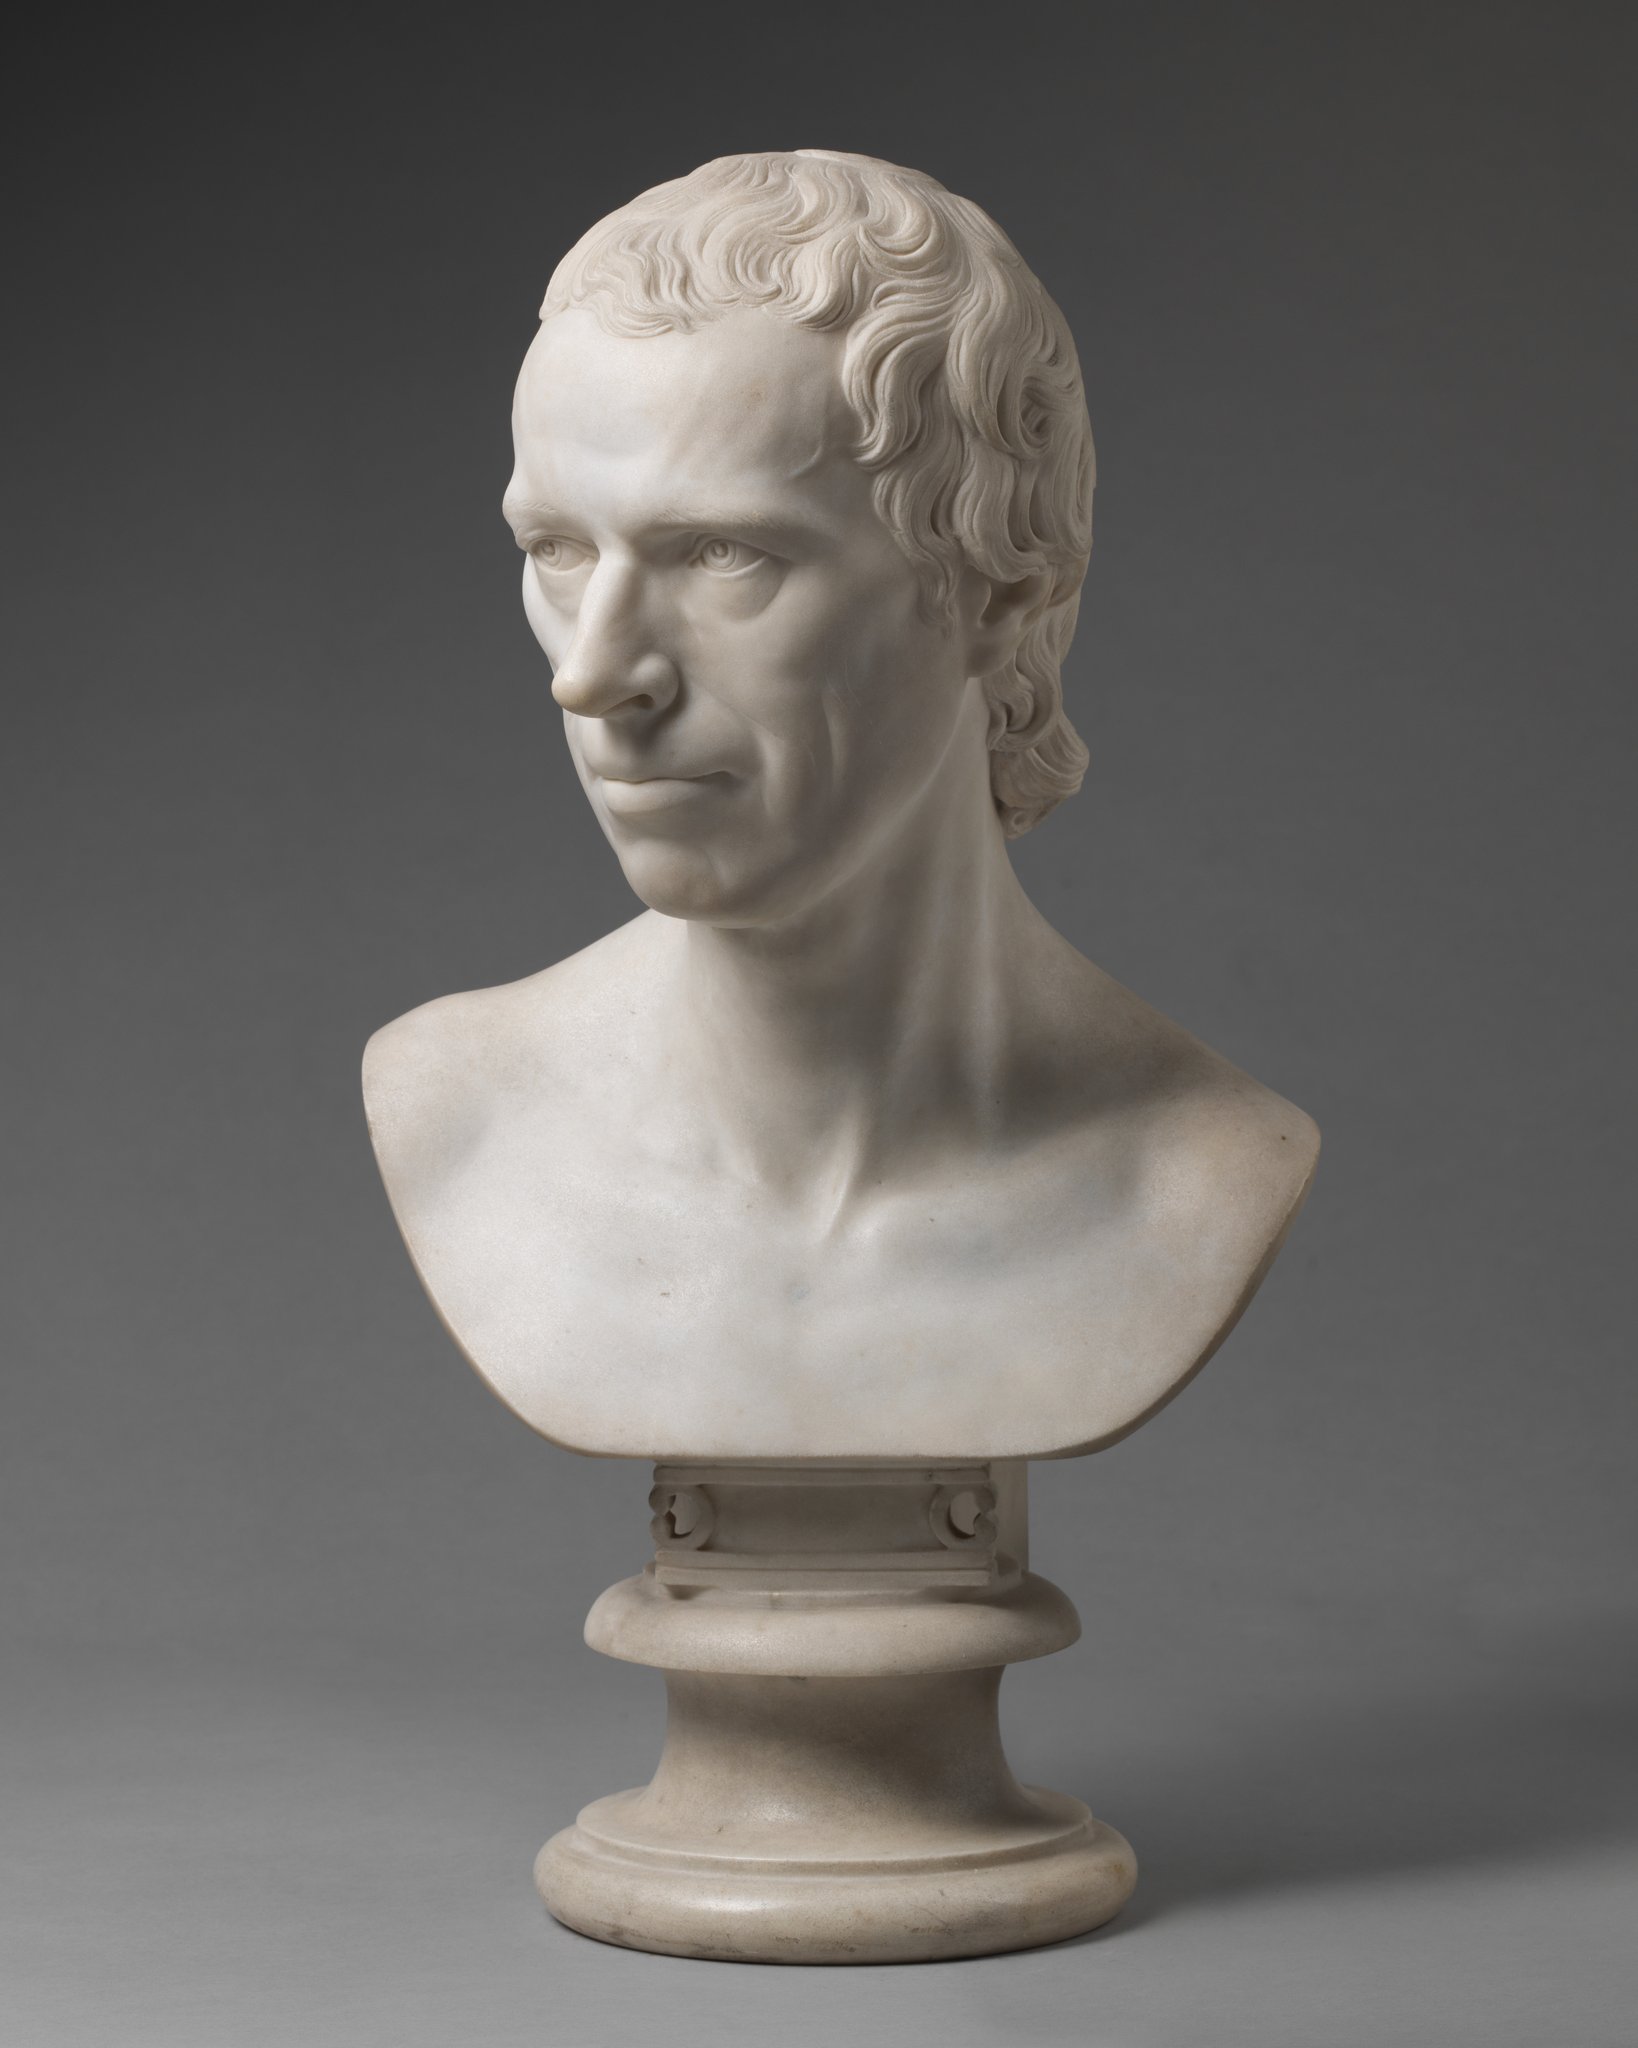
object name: bust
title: Laurence Sterne (1713–1768)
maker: joseph nollekens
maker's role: artist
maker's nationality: british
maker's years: 1737-1823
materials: marble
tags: men,portraits